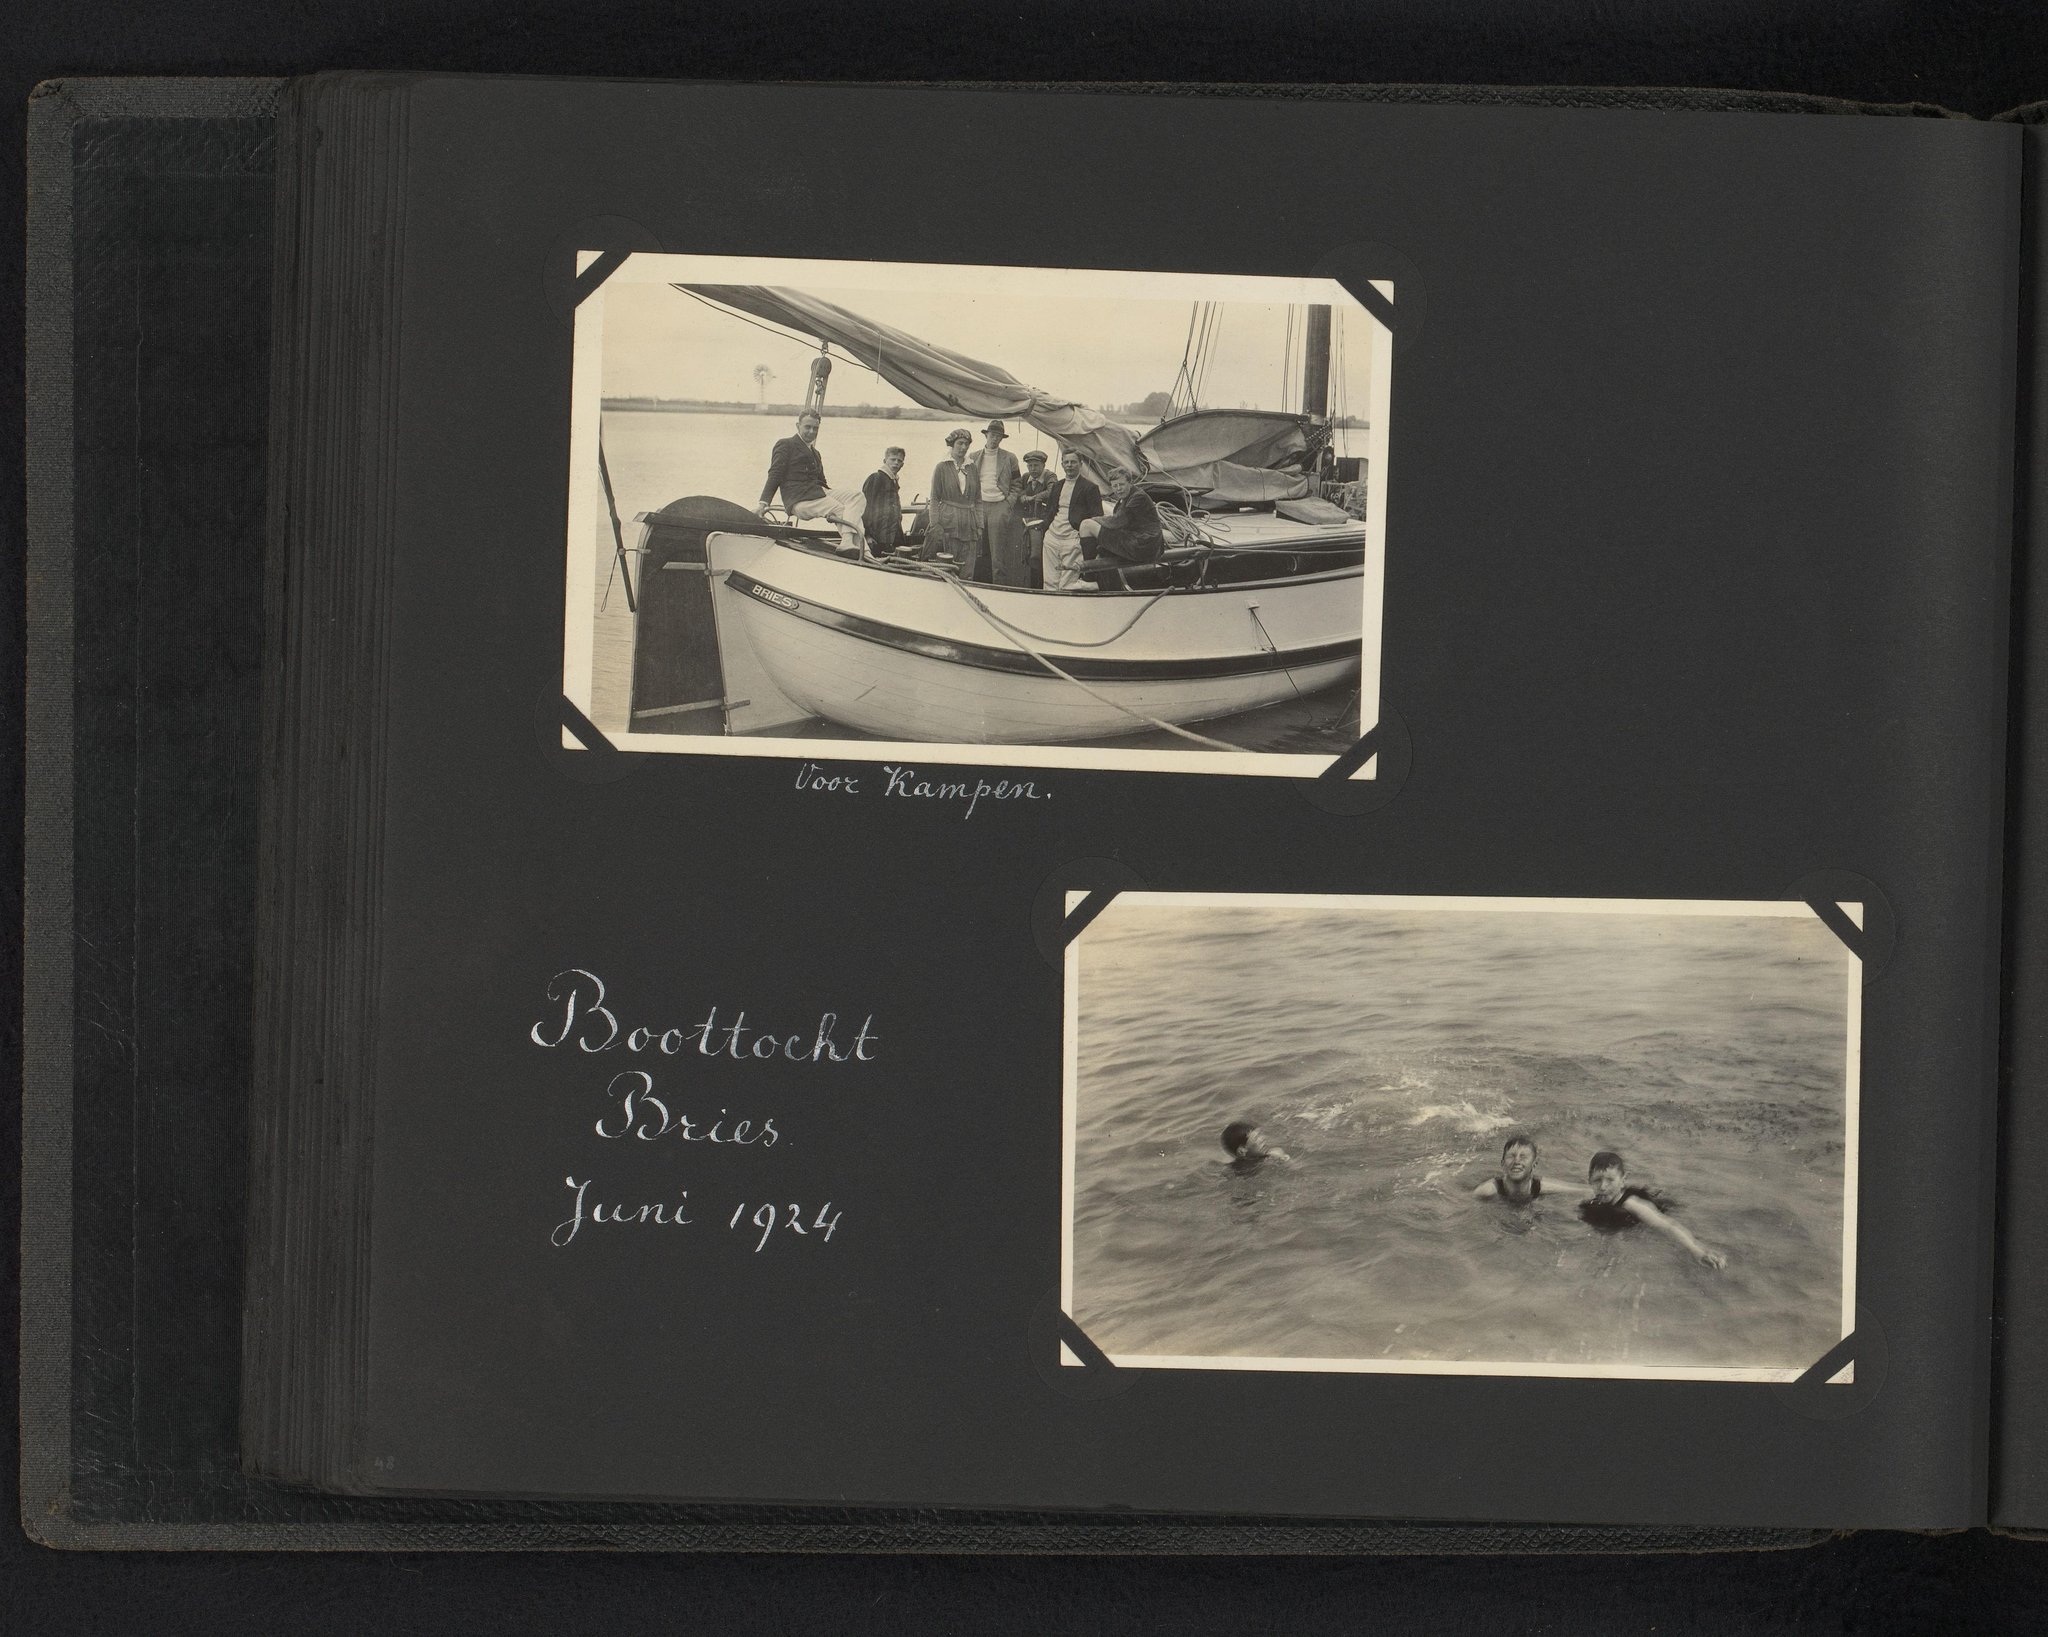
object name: photograph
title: Boottocht Bries Juni 1924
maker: hendrik herman van den berg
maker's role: amateurfotograaf, jurist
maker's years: 1875-1944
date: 1906-1924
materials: paper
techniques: gelatin silver print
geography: overijssel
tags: carel frederik van den berg (cay), amsterdam, frank willem van den berg (1912-1998), sailing-ship, sailing-boat, swimming (movement in water)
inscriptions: inscription: ‘Voor Kampen’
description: Deze foto's maken deel uit van een album.